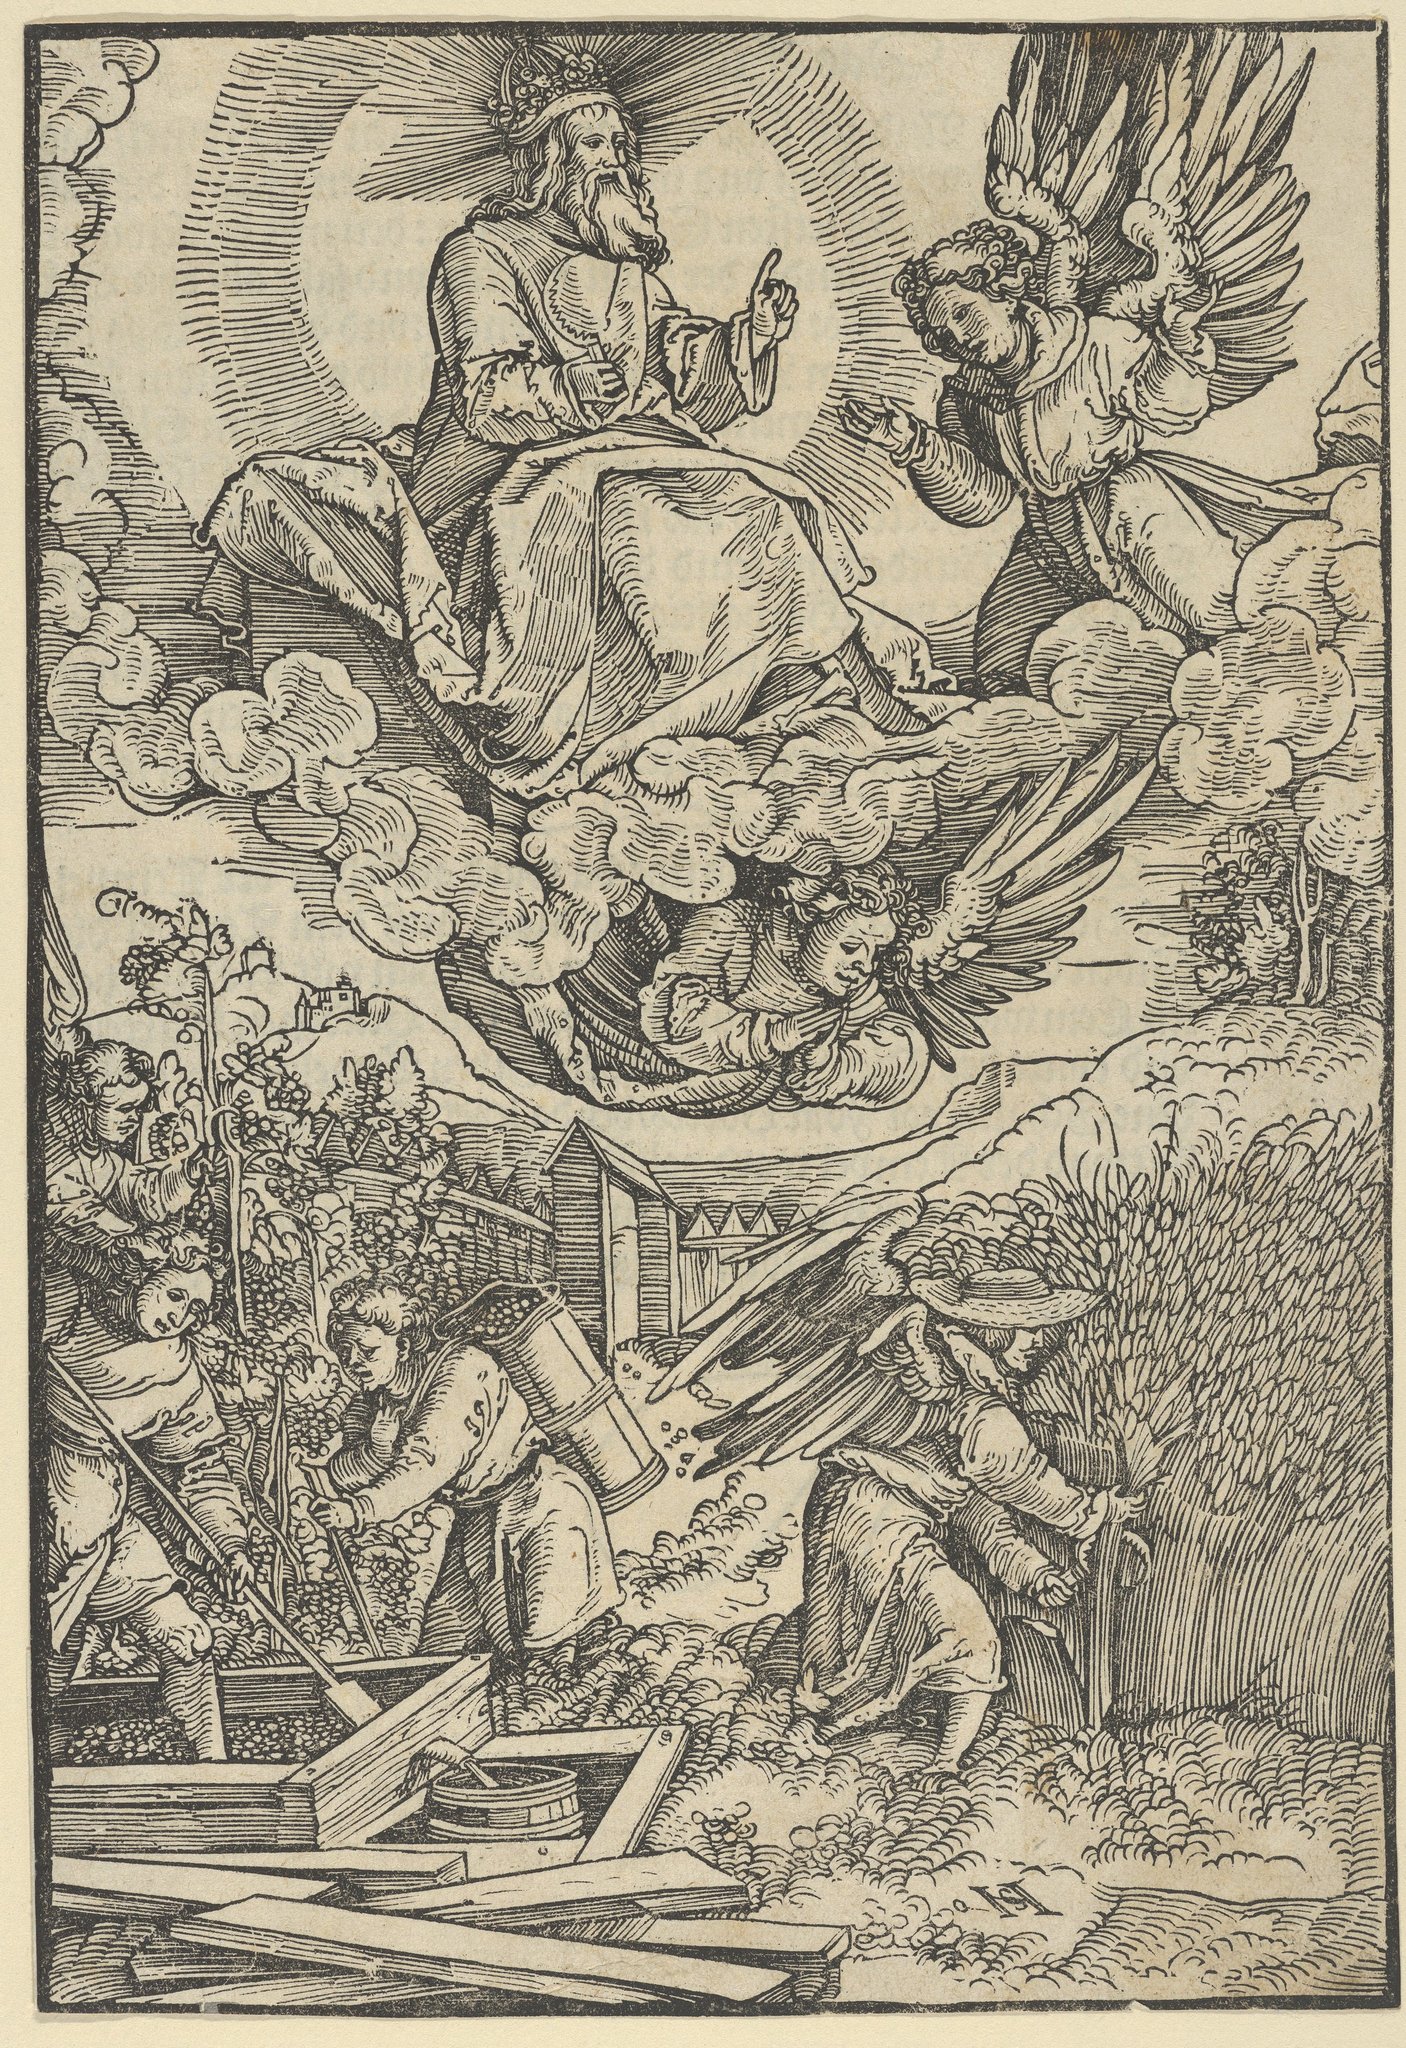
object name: print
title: The Harvest and the Wine-Press of Blood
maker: hans schäufelein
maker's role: artist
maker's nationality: german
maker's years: 1480-1540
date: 1500-1540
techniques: woodcut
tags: farms,men,angels,saints,working